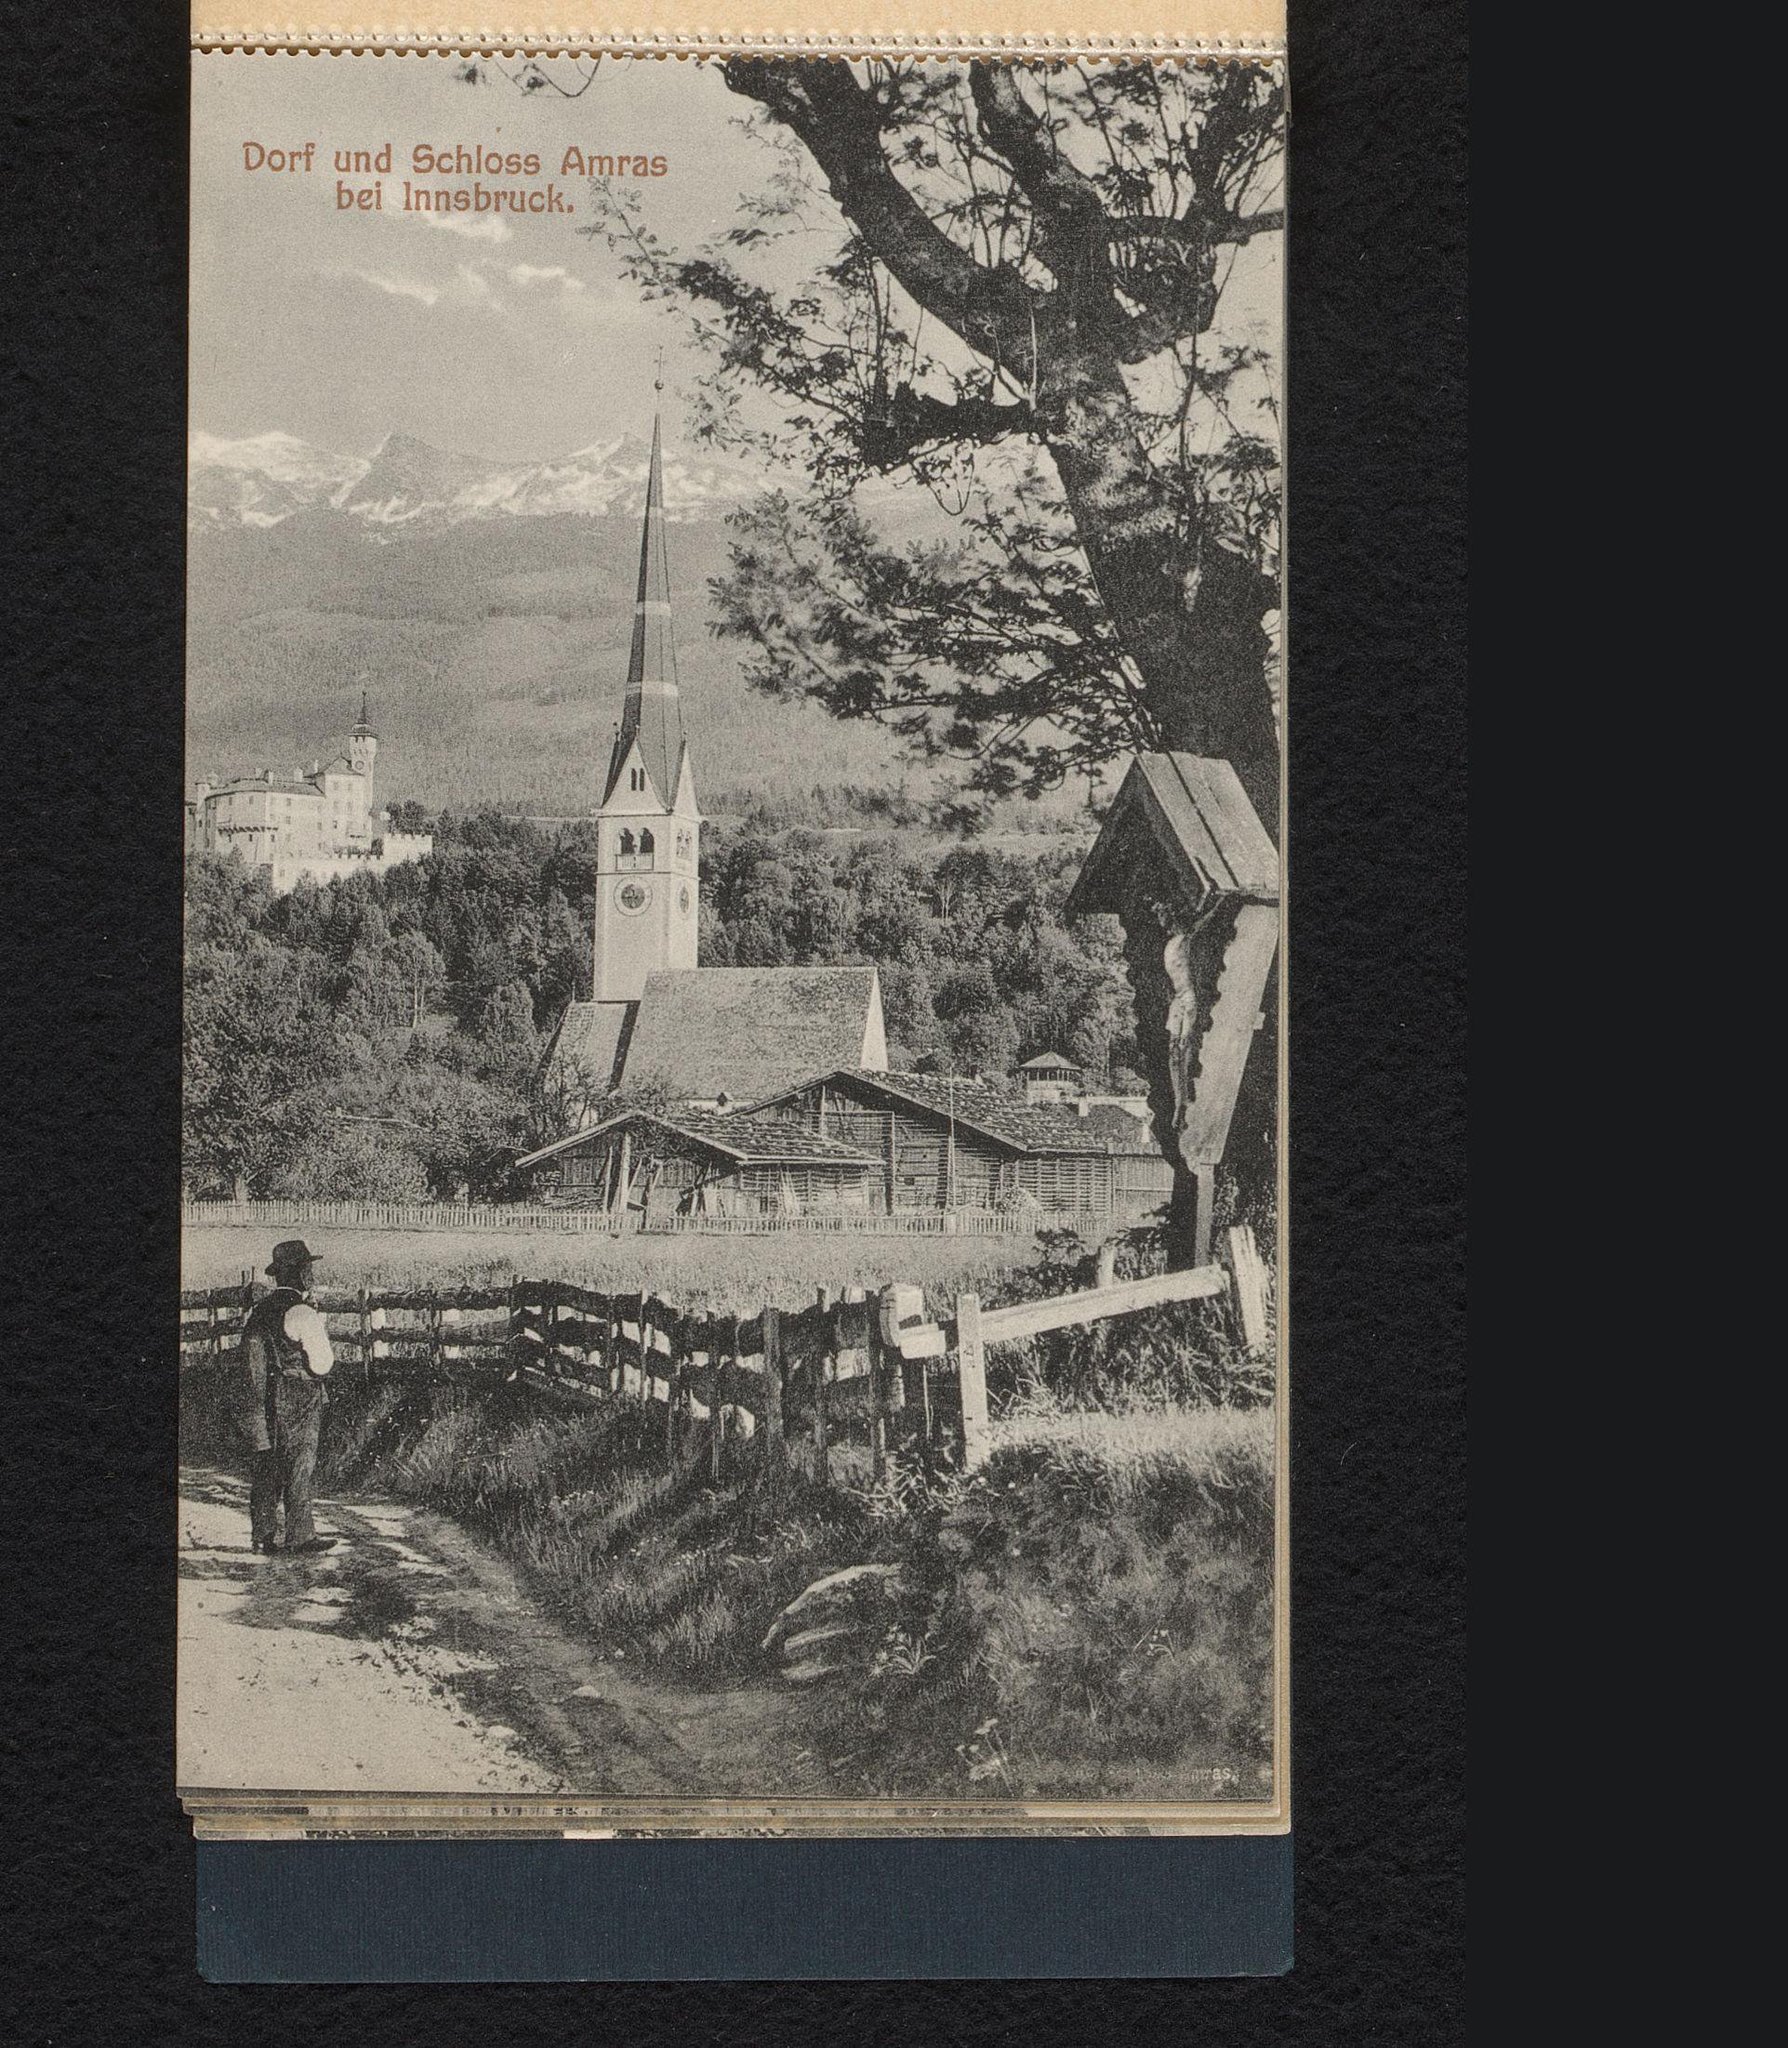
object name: photomechanical print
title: Dorf und Schloss Amras bei Innsbruck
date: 1904-1930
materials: cardboard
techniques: photograph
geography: amras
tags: city-view, and landscape with man-made constructions, castle, church (exterior)